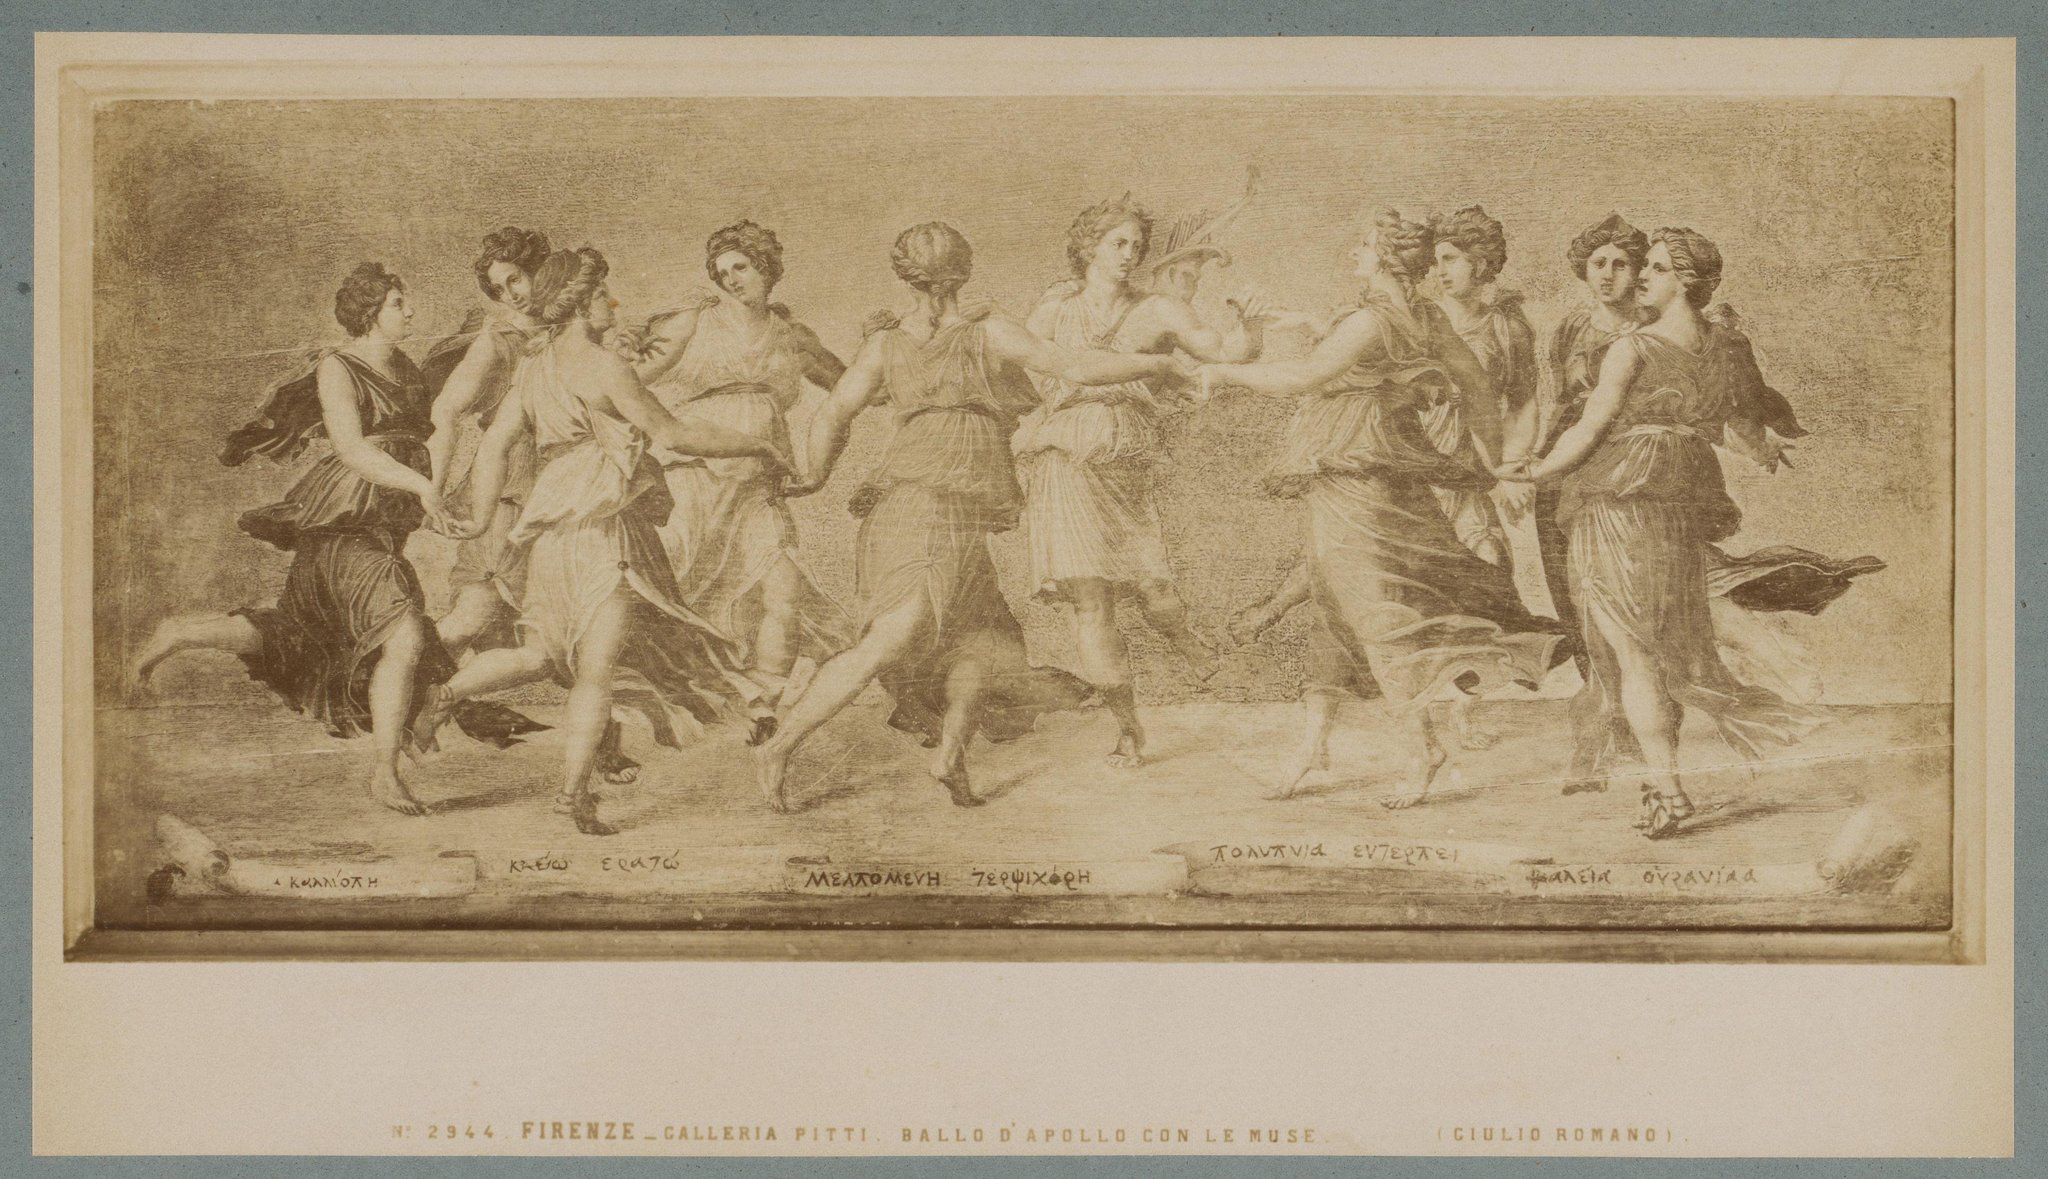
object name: reproduction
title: Galleria Pitti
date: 1851-1900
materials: cardboard, paper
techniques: albumen print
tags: apollo and the muses, apollo musagetes, picture, painting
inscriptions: collector's mark: ‘VOSMAER’, number: ‘No. 2944’